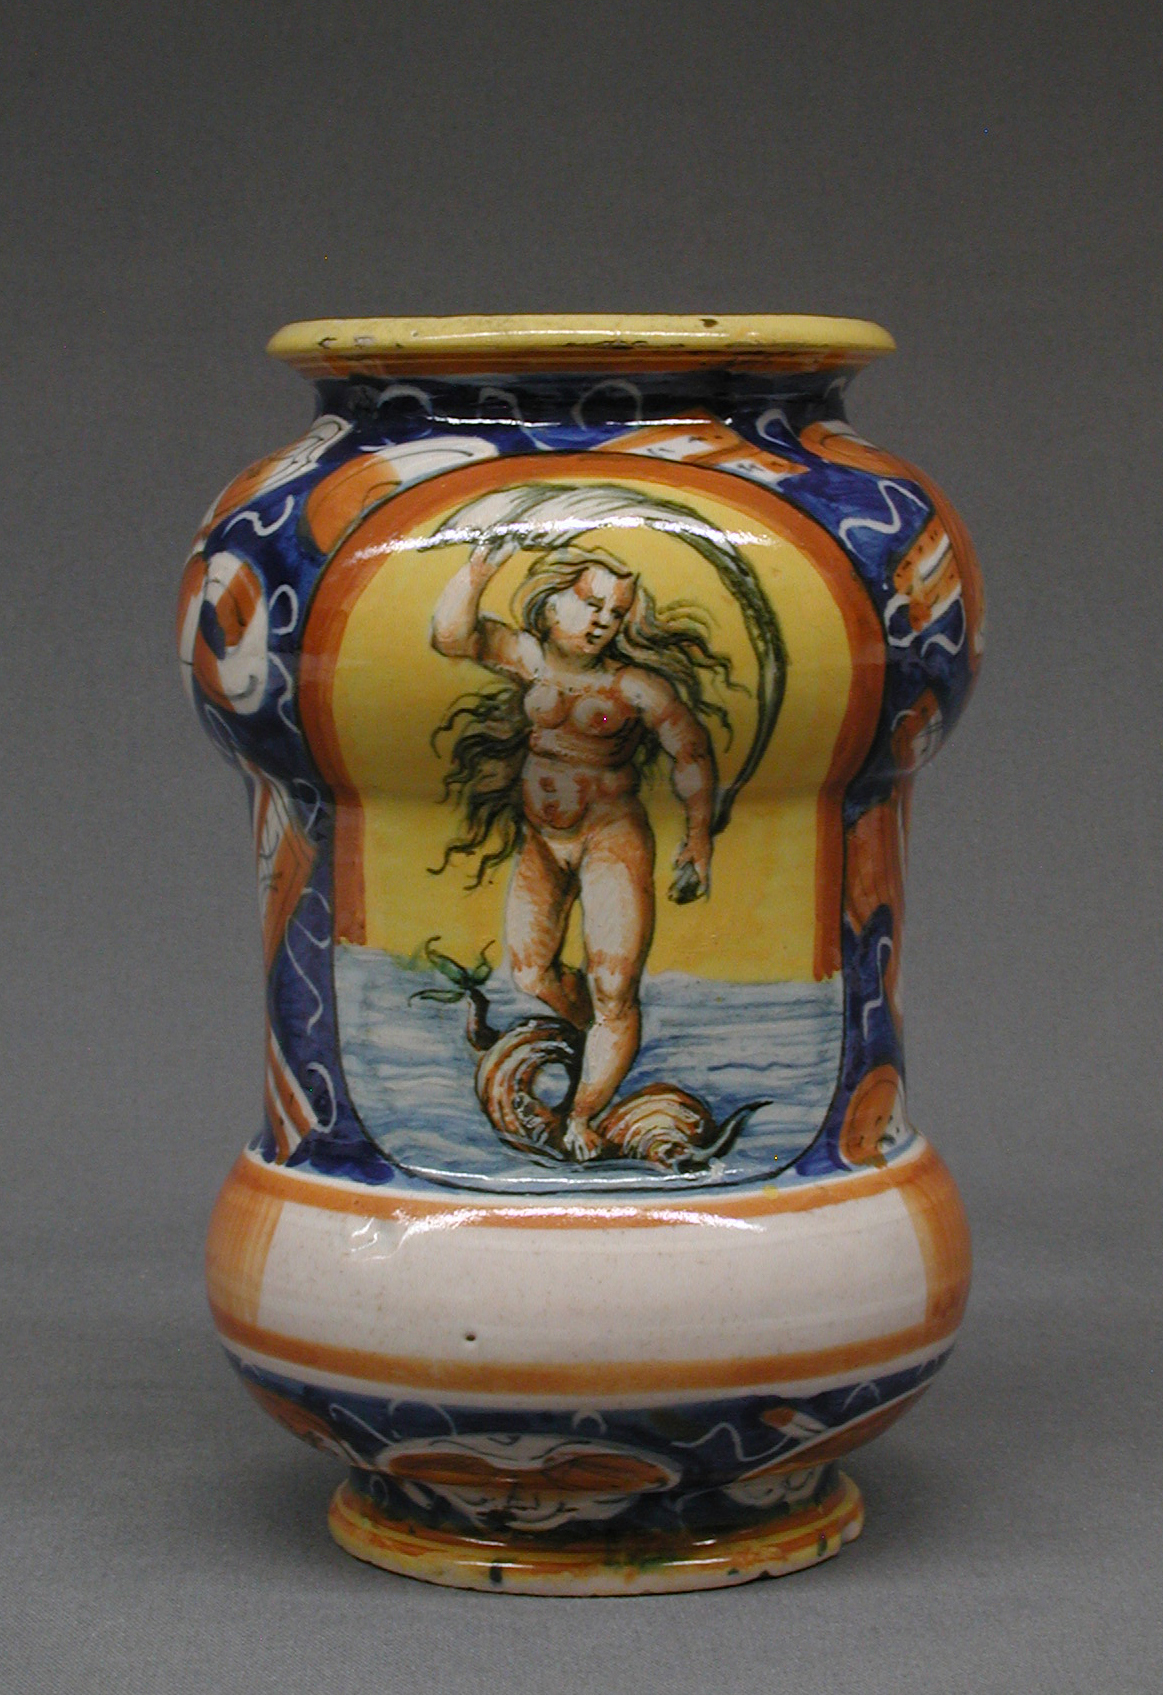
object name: pharmacy jar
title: Pharmacy jar (albarello) (one of a pair)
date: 1579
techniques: maiolica, glazing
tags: goddess